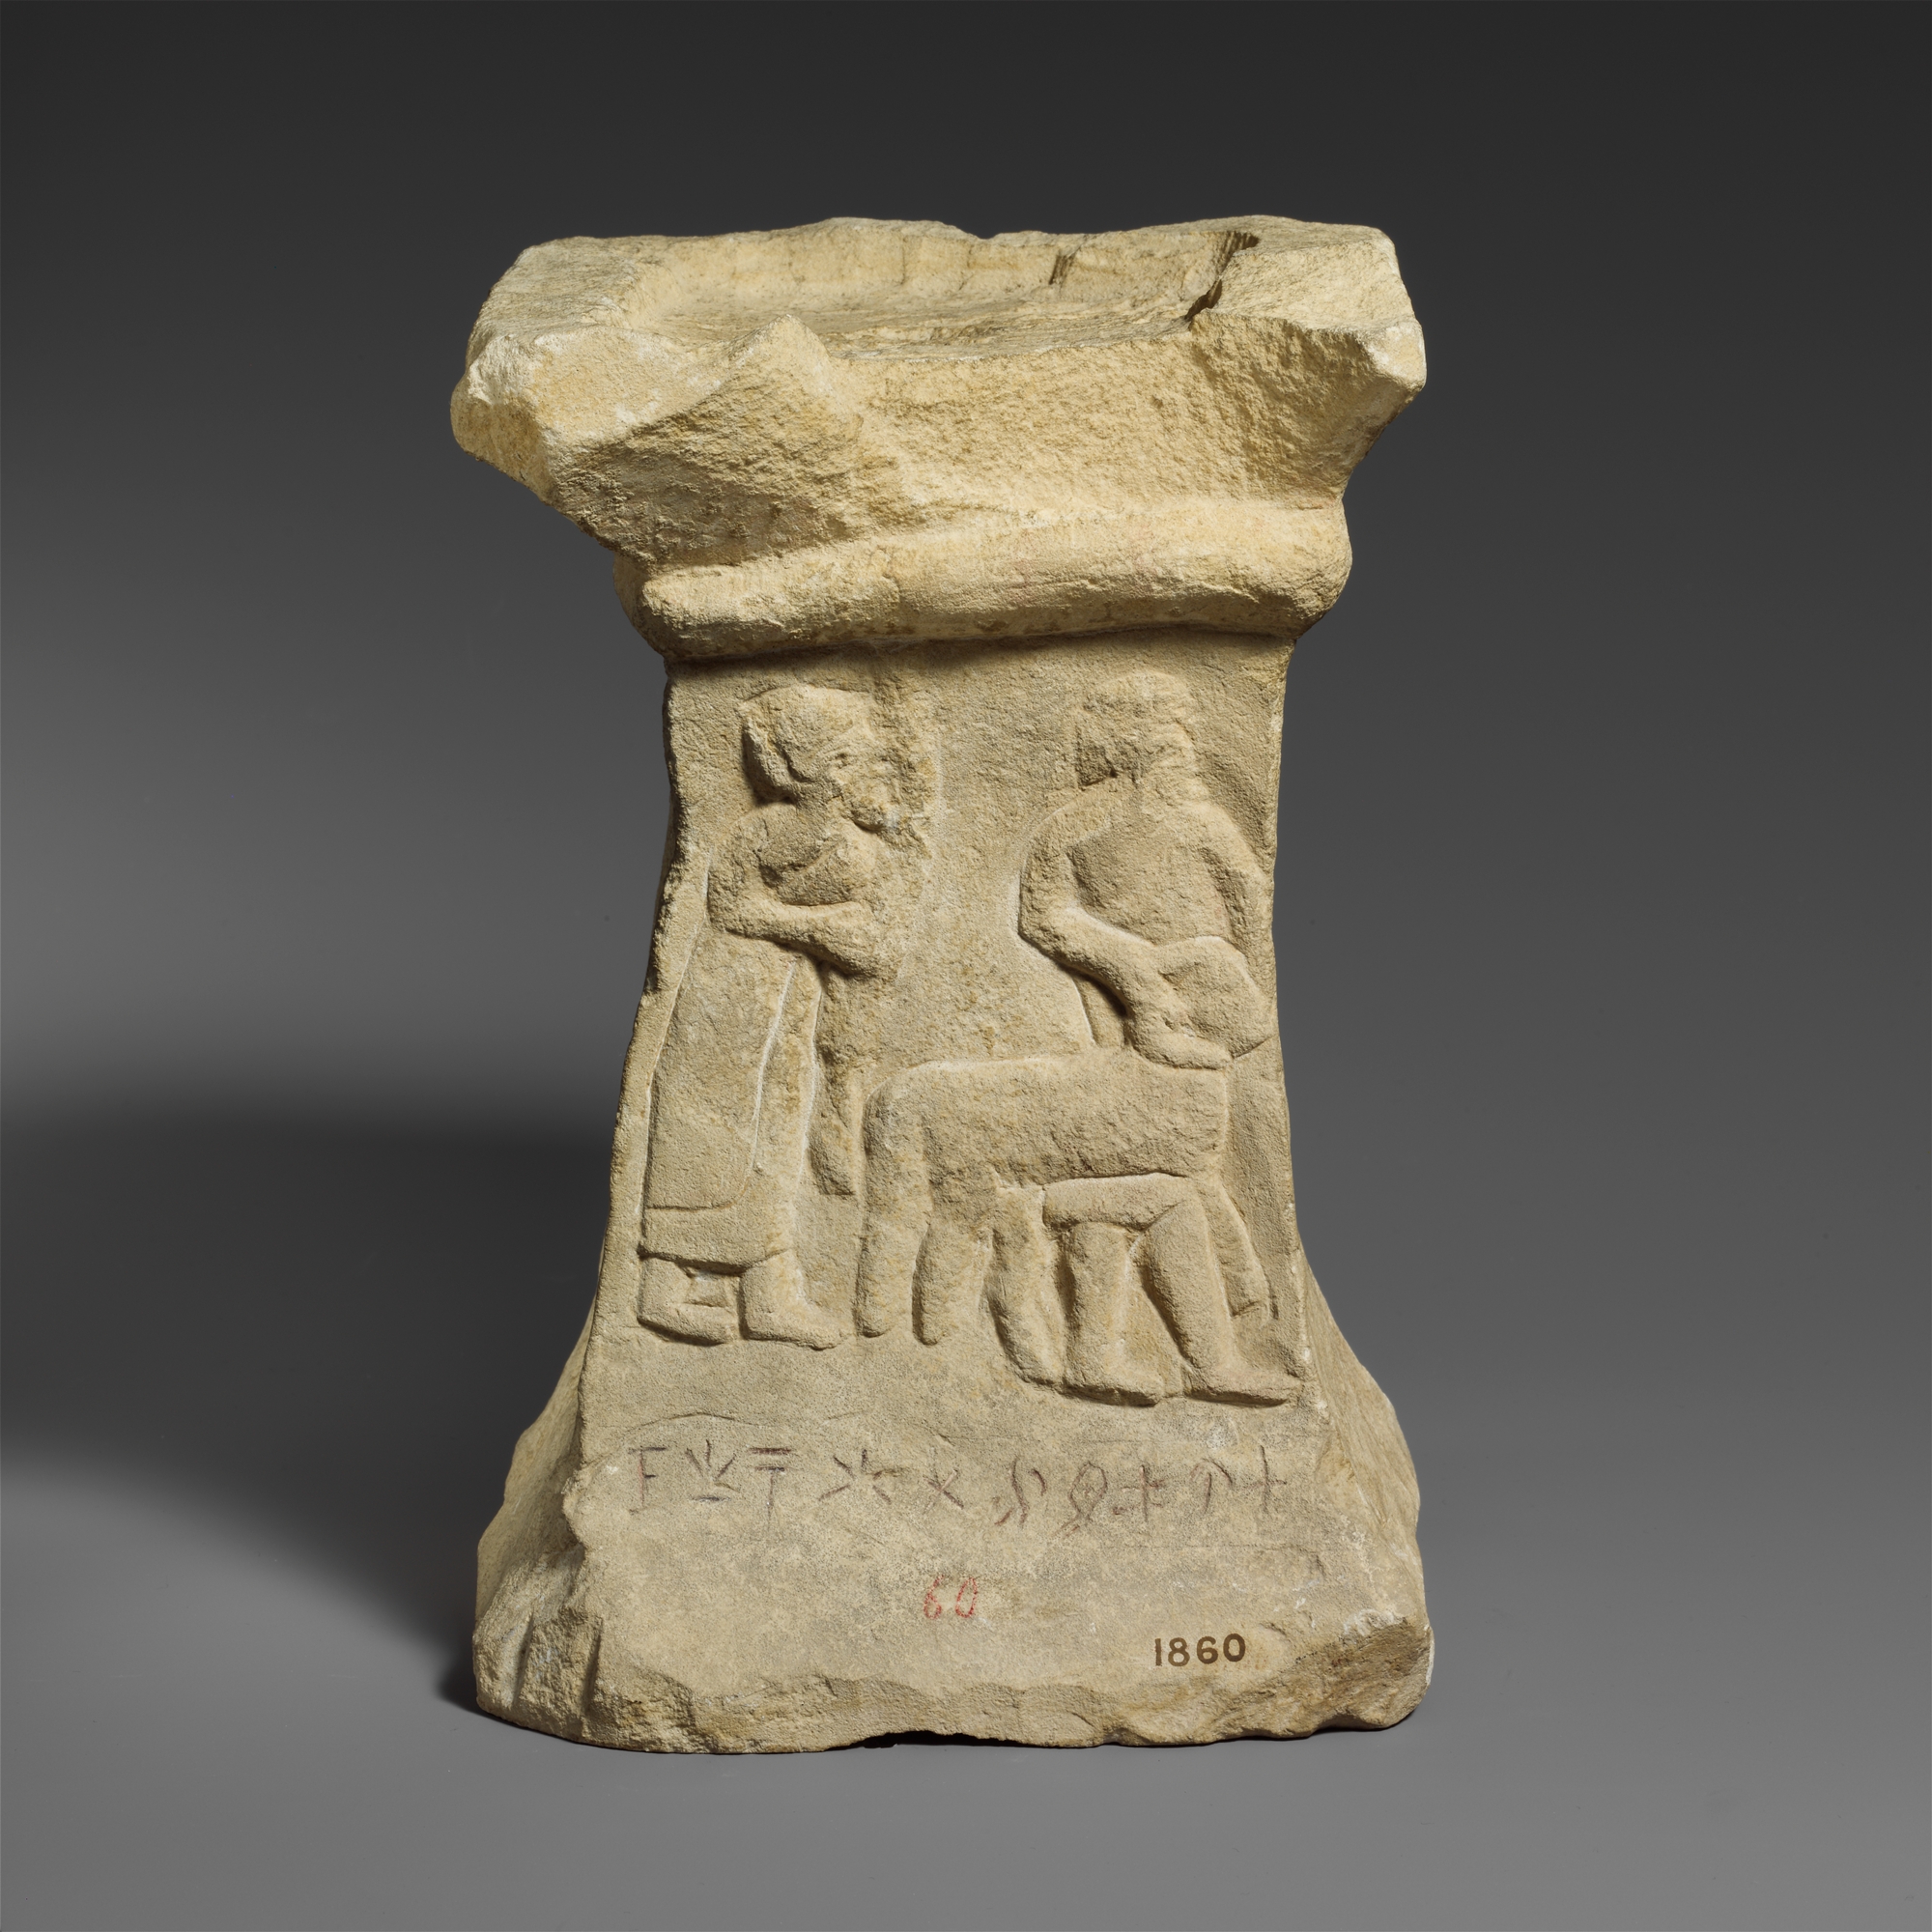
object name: altar, miniature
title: Limestone altar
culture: cypriot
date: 500-451 BCE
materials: limestone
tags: animals,men